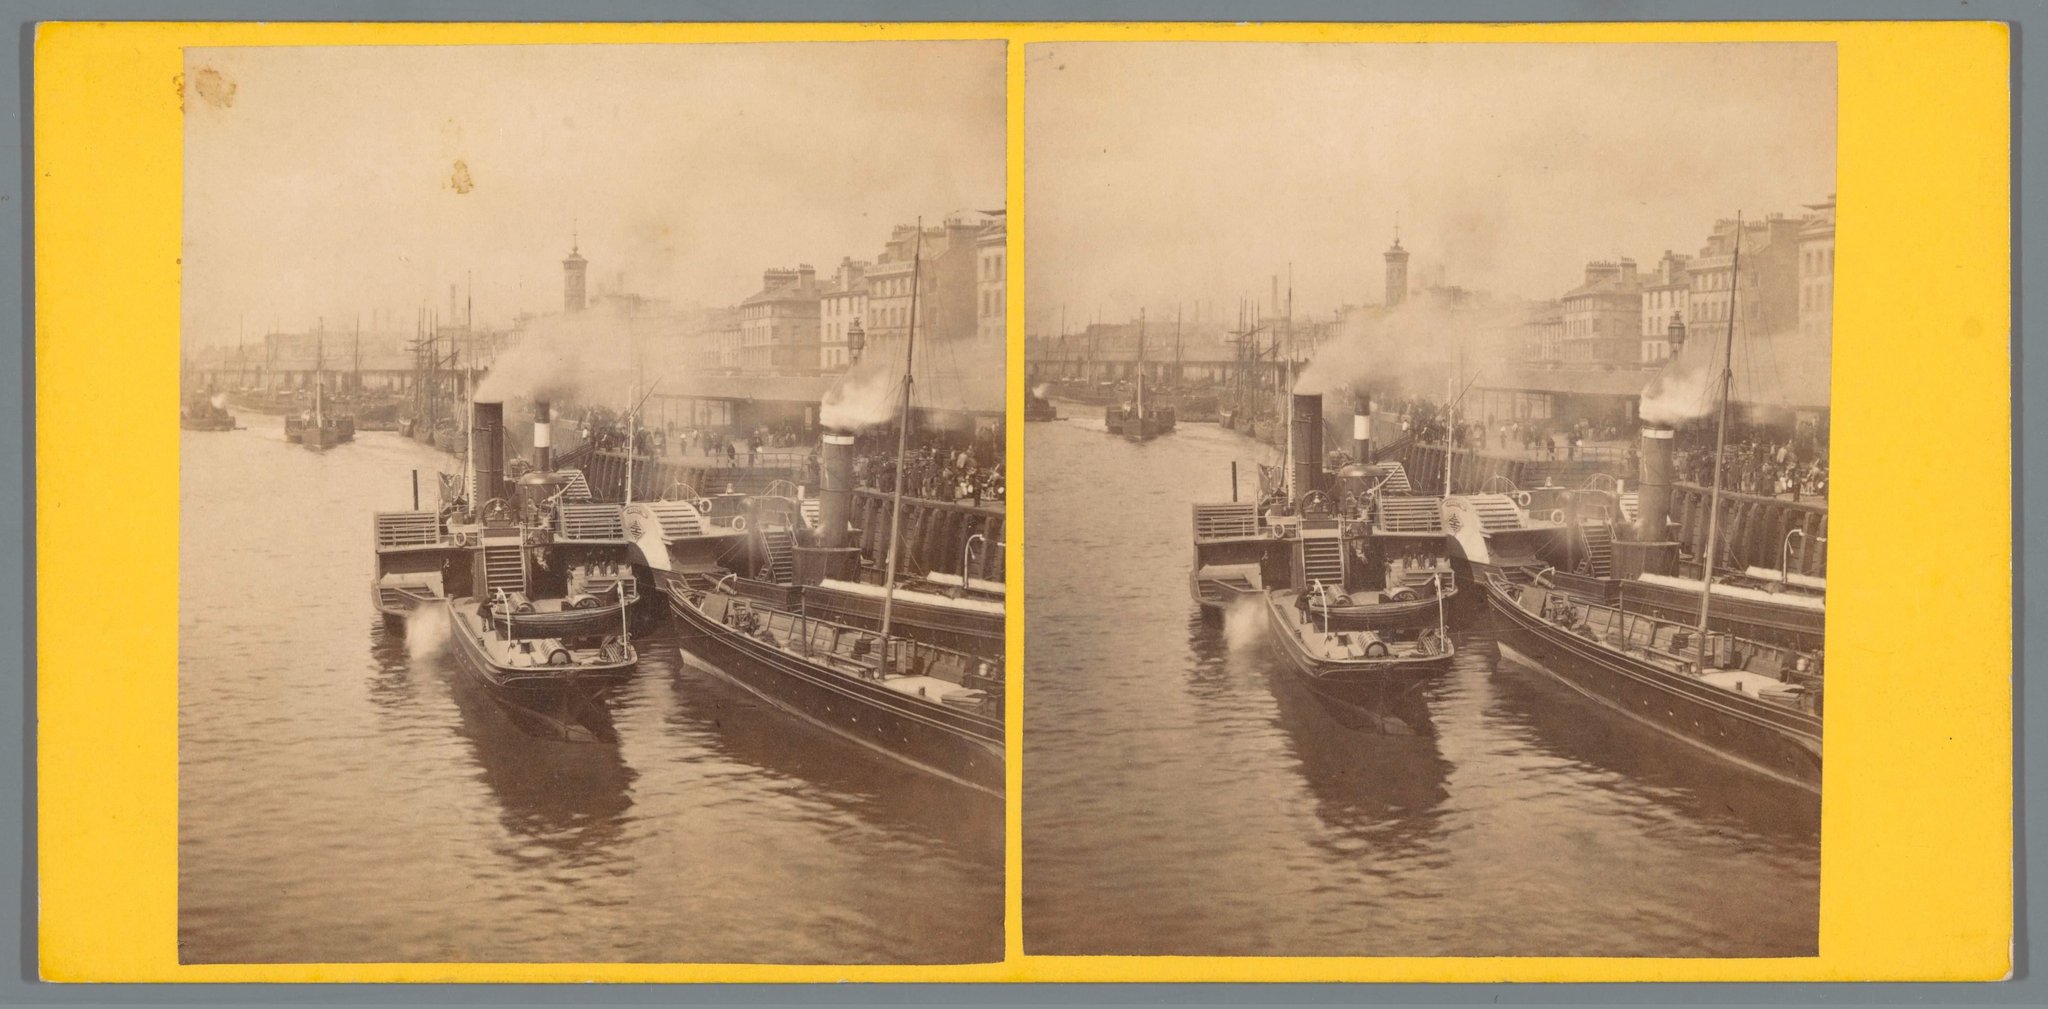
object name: stereograph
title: Glasgow – The Broomielaw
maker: george washington wilson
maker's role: publisher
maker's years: 1823-1893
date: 1860-1865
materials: cardboard, photographic support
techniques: albumen print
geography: aberdeen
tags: schotland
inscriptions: label: ‘G.W. Wilson & Co, Aberdeen No. 810 Glasgow – The Broomielaw’